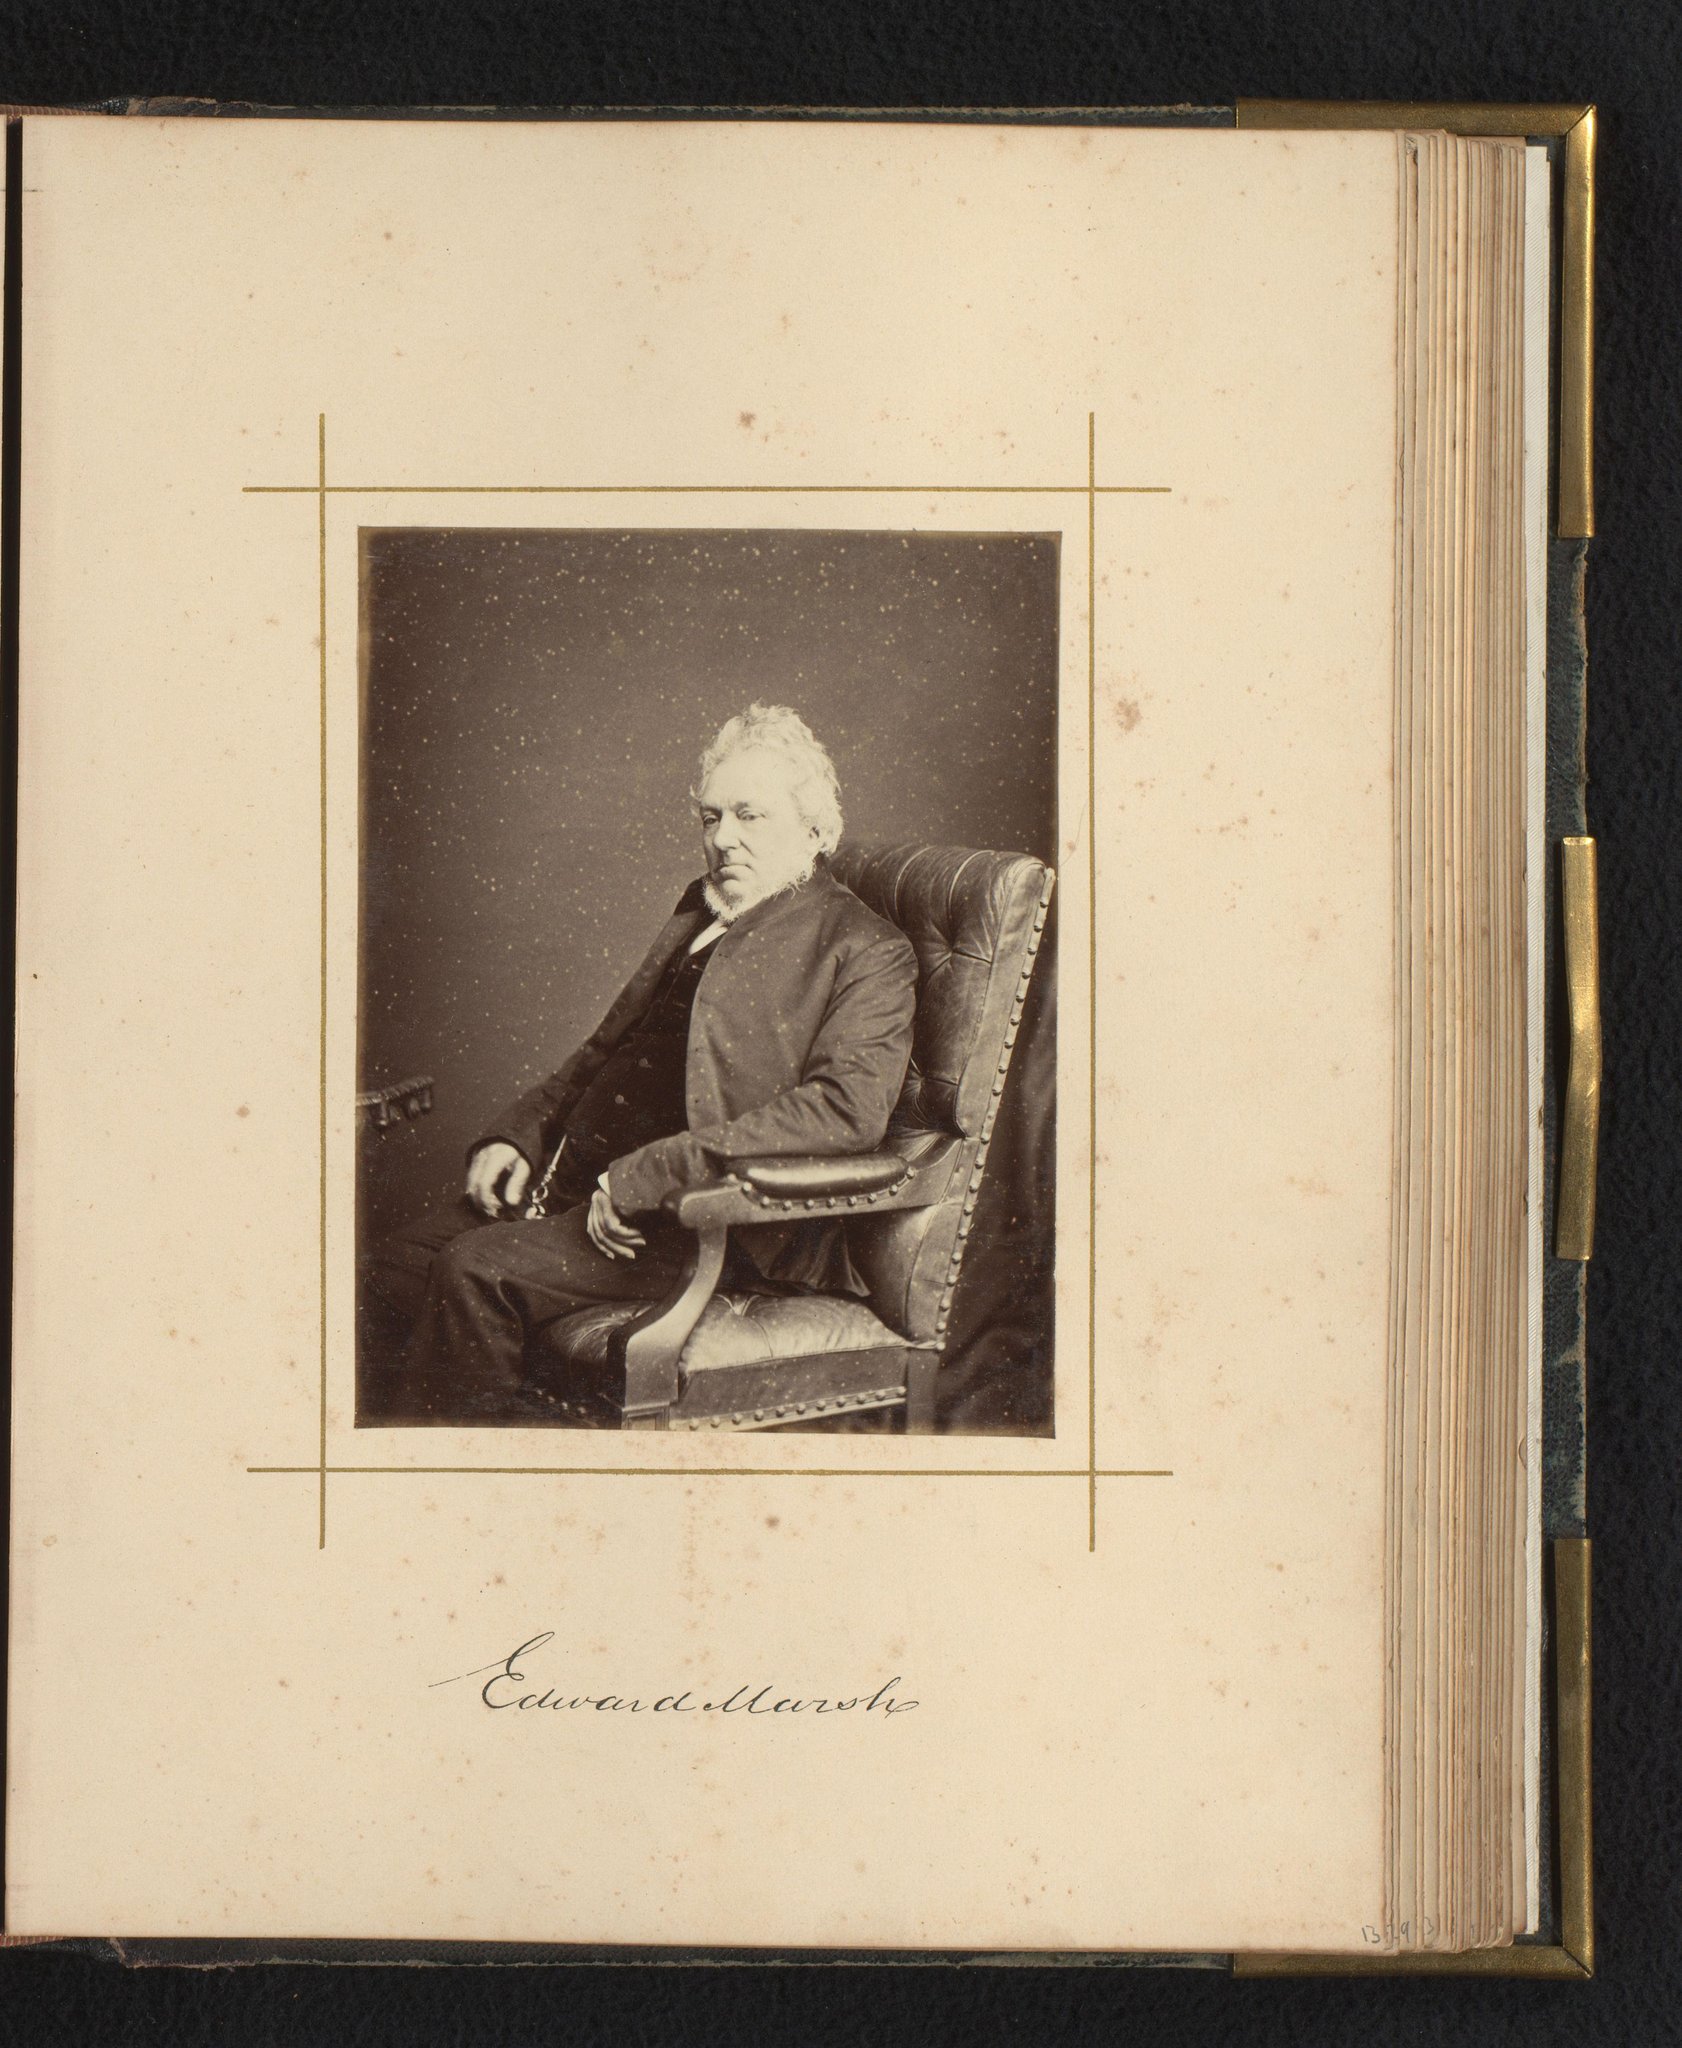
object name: photograph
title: Portret van Edward Marsh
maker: Anonymous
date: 1866-1871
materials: photographic support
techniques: albumen print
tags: historical persons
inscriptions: name: ‘Edward Marsh’